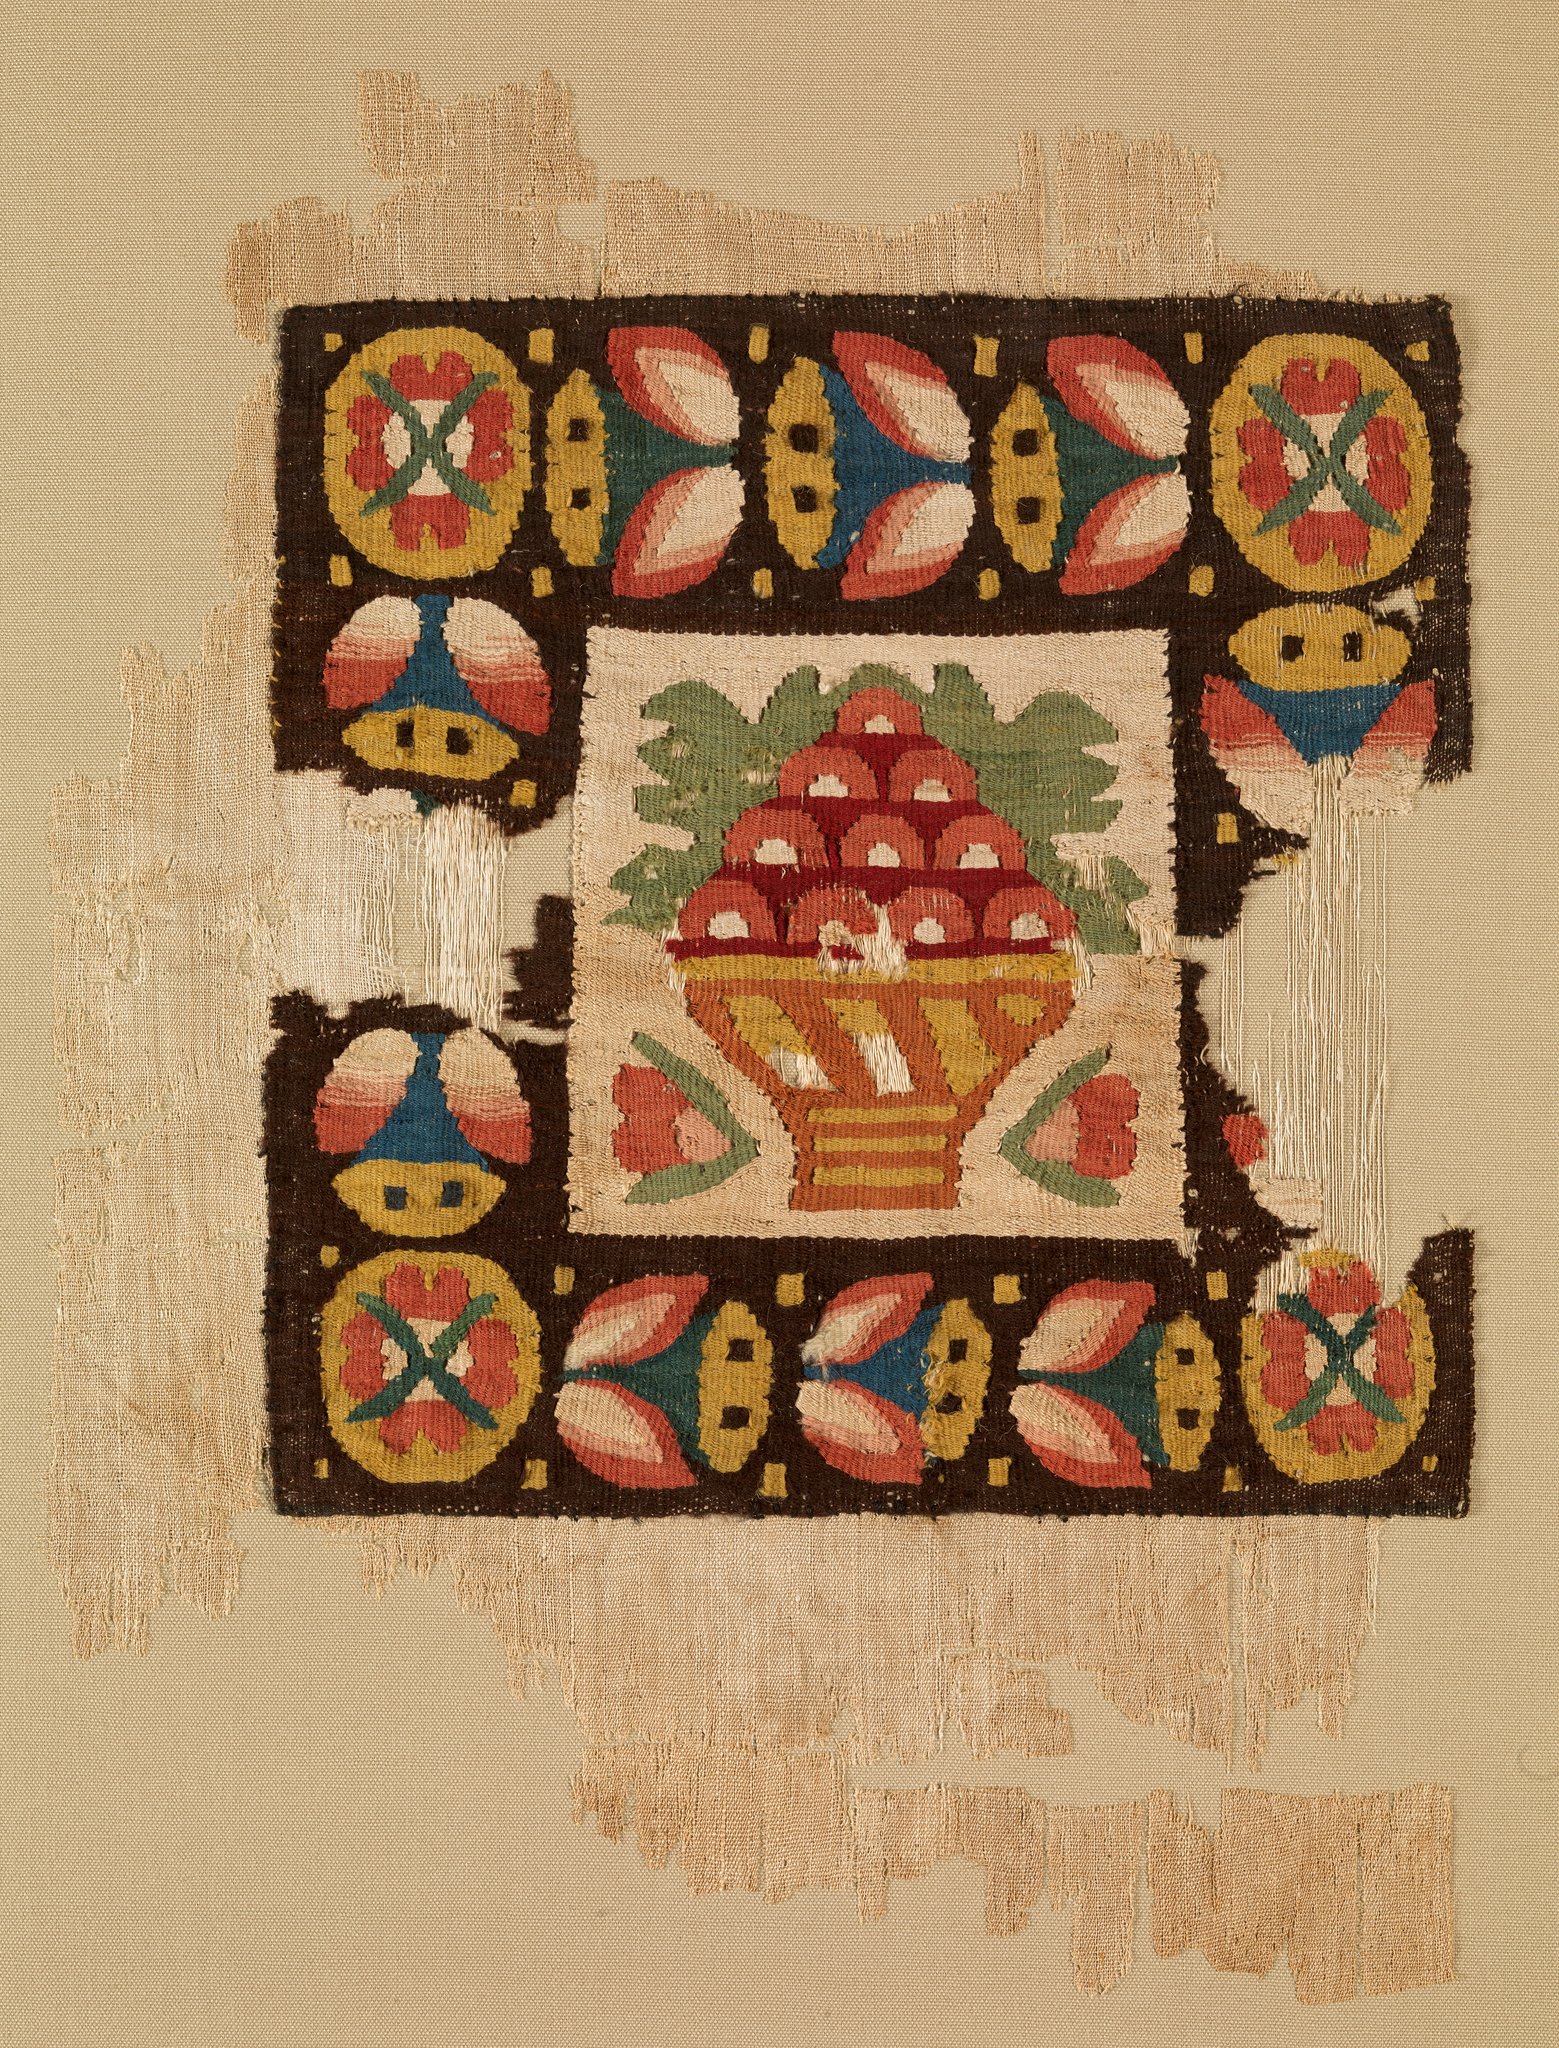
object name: textile fragment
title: Square with Quail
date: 401-500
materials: linen, wool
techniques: weave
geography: egypt